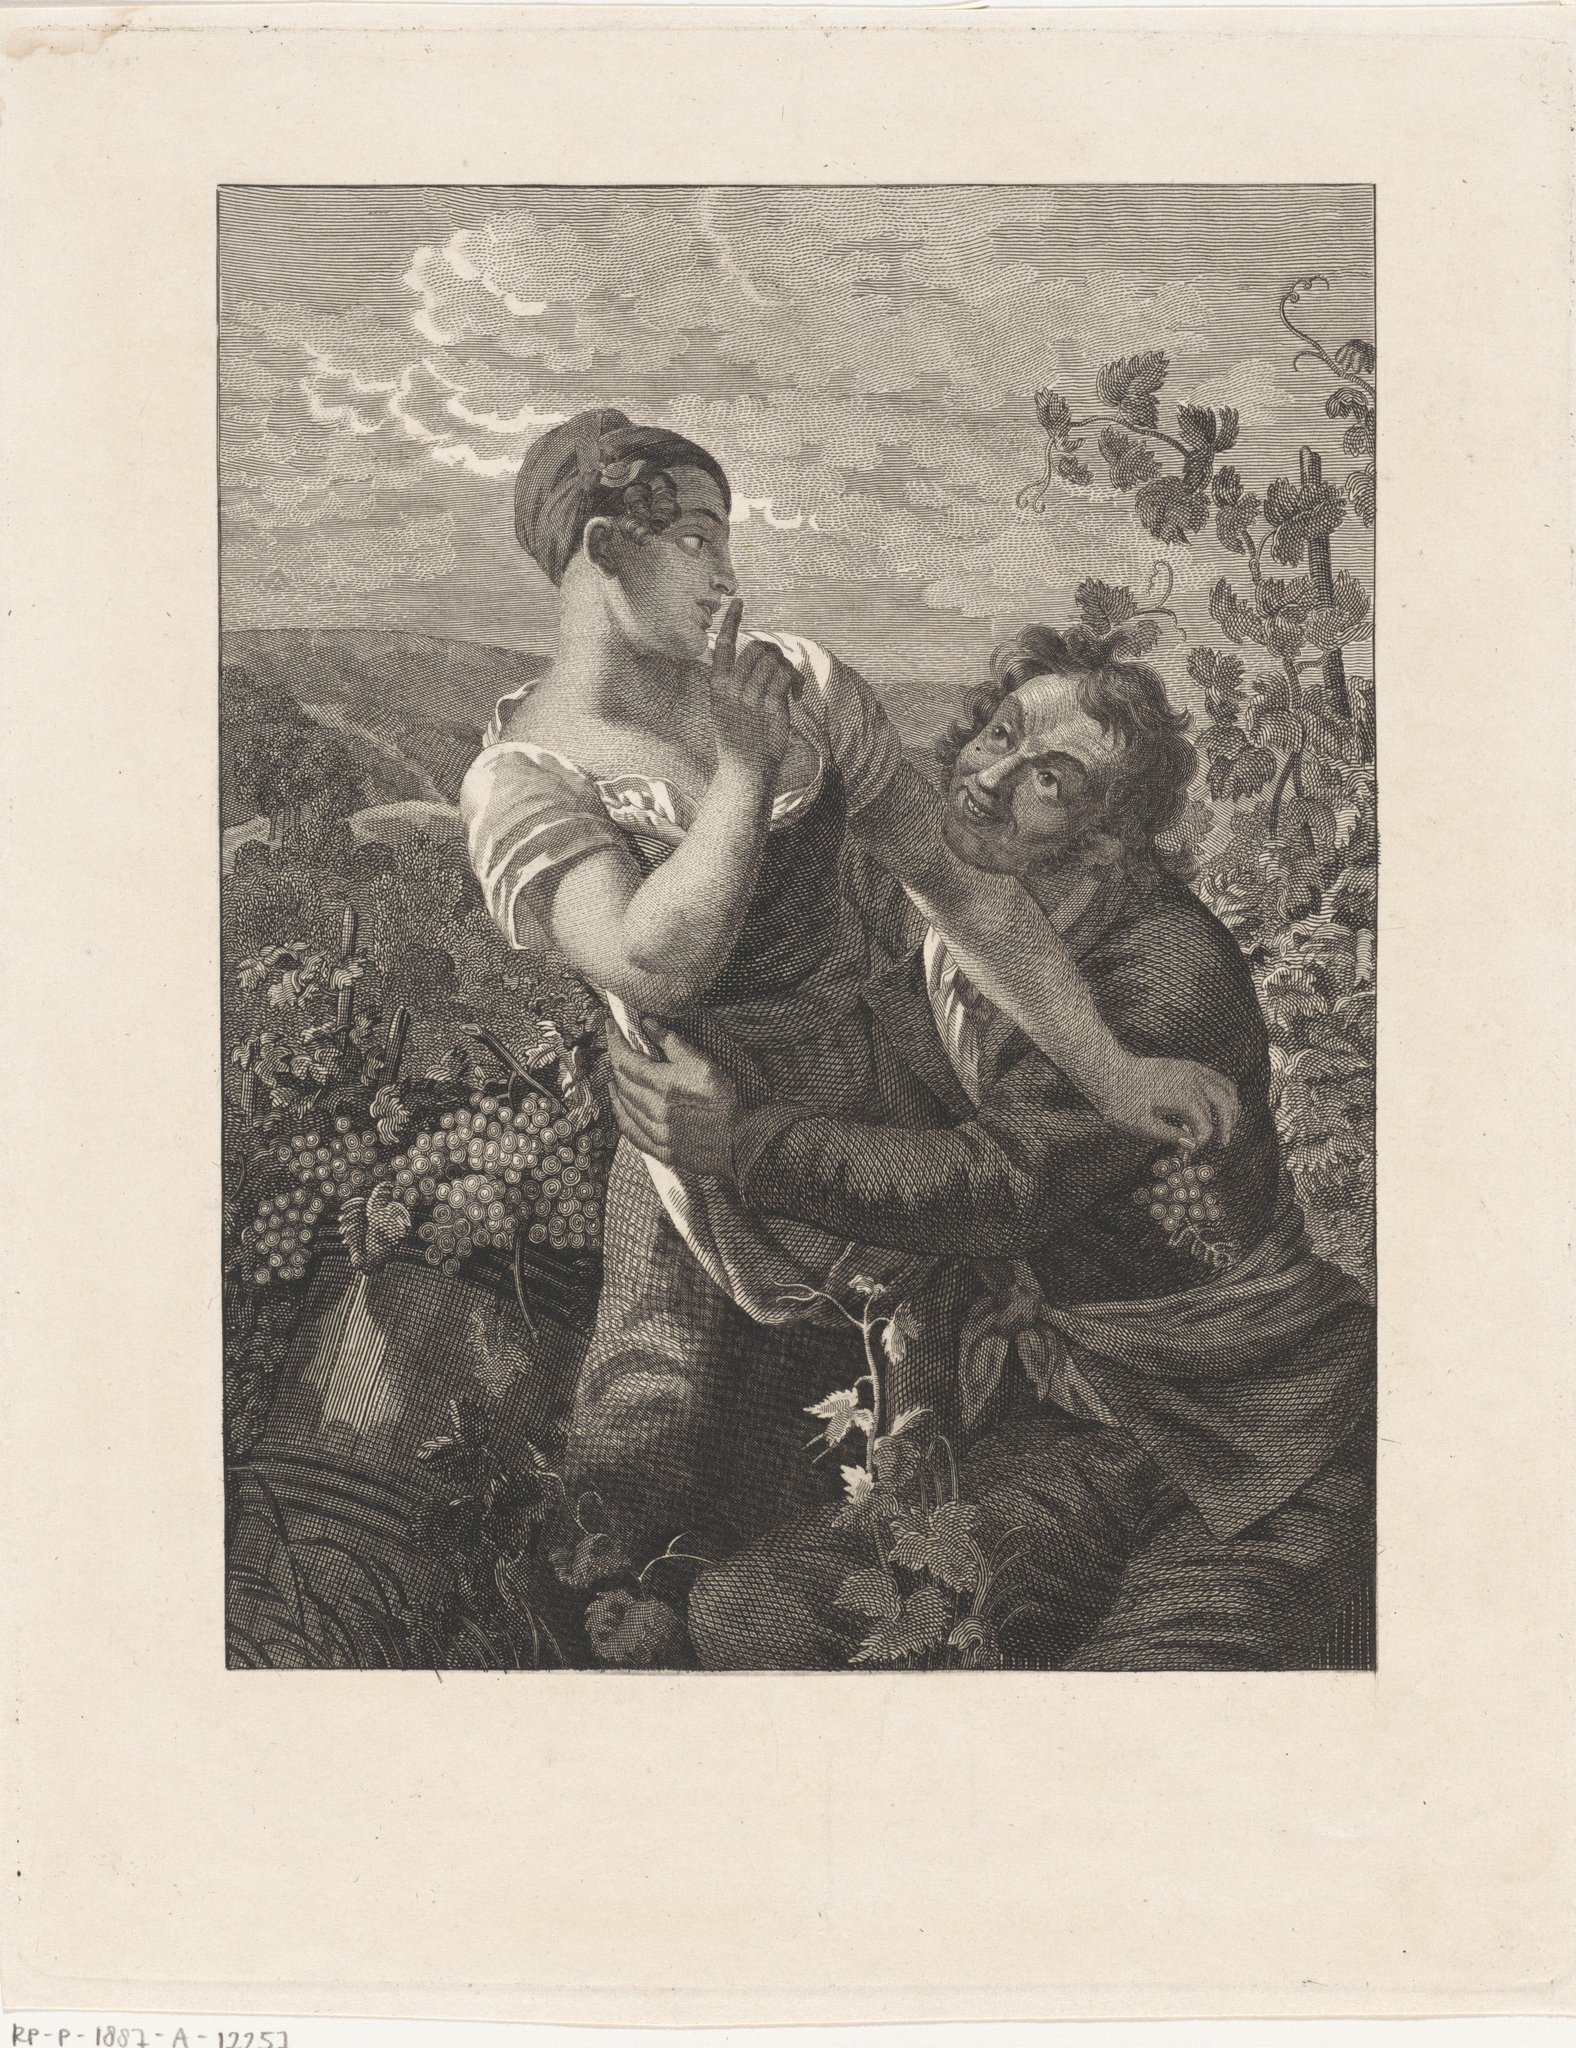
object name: print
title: Verliefde wijngaardenier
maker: Anonymous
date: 1817-1867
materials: paper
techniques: engraving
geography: low countries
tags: vineyard, unsuccessful love affair; seduction, vintage, grape harvest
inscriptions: collector's mark: Lugt 2228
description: Tijdens het druivenplukken grijpt een man een jonge vrouw om haar middel. Zij spreekt hem met opgeheven vinger toe.